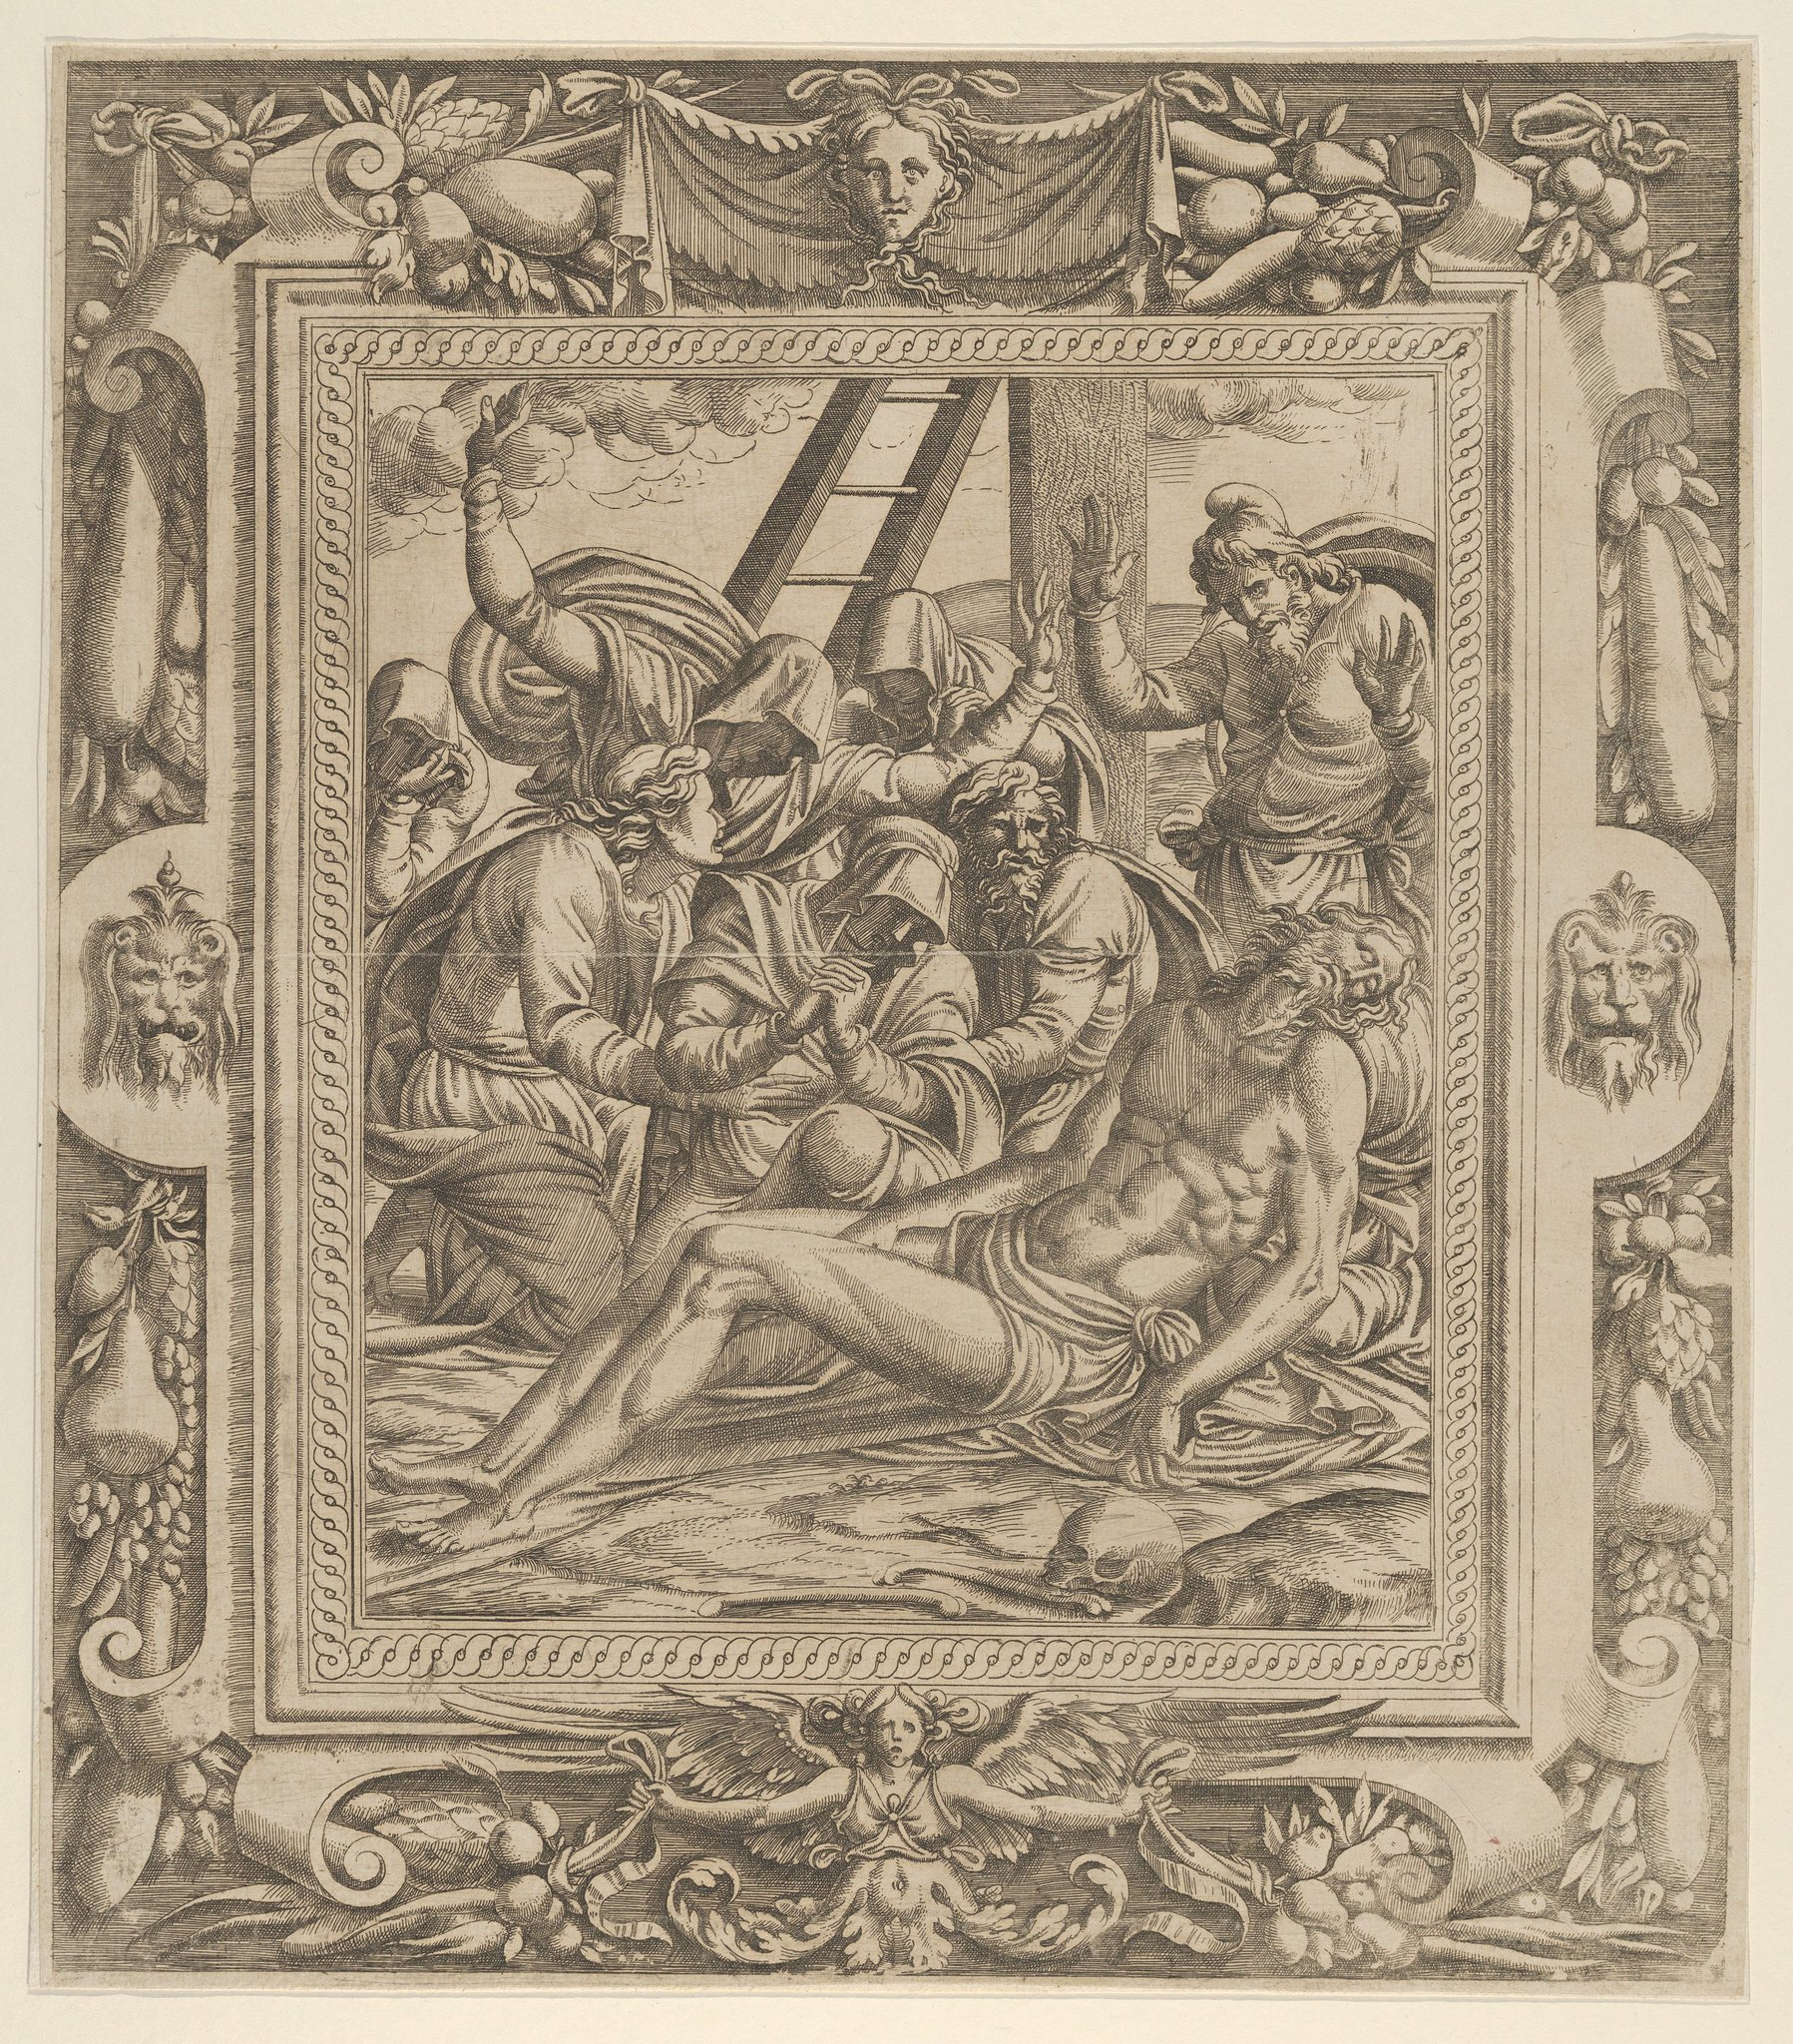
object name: print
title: The Lamentation over Christ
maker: jean mignon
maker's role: artist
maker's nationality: french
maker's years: 1535-1555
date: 1535-1555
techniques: etching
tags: men,angels,christ,lamentation